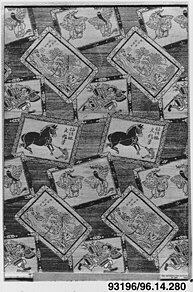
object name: piece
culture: japanese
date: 1701-1900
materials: silk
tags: human figures